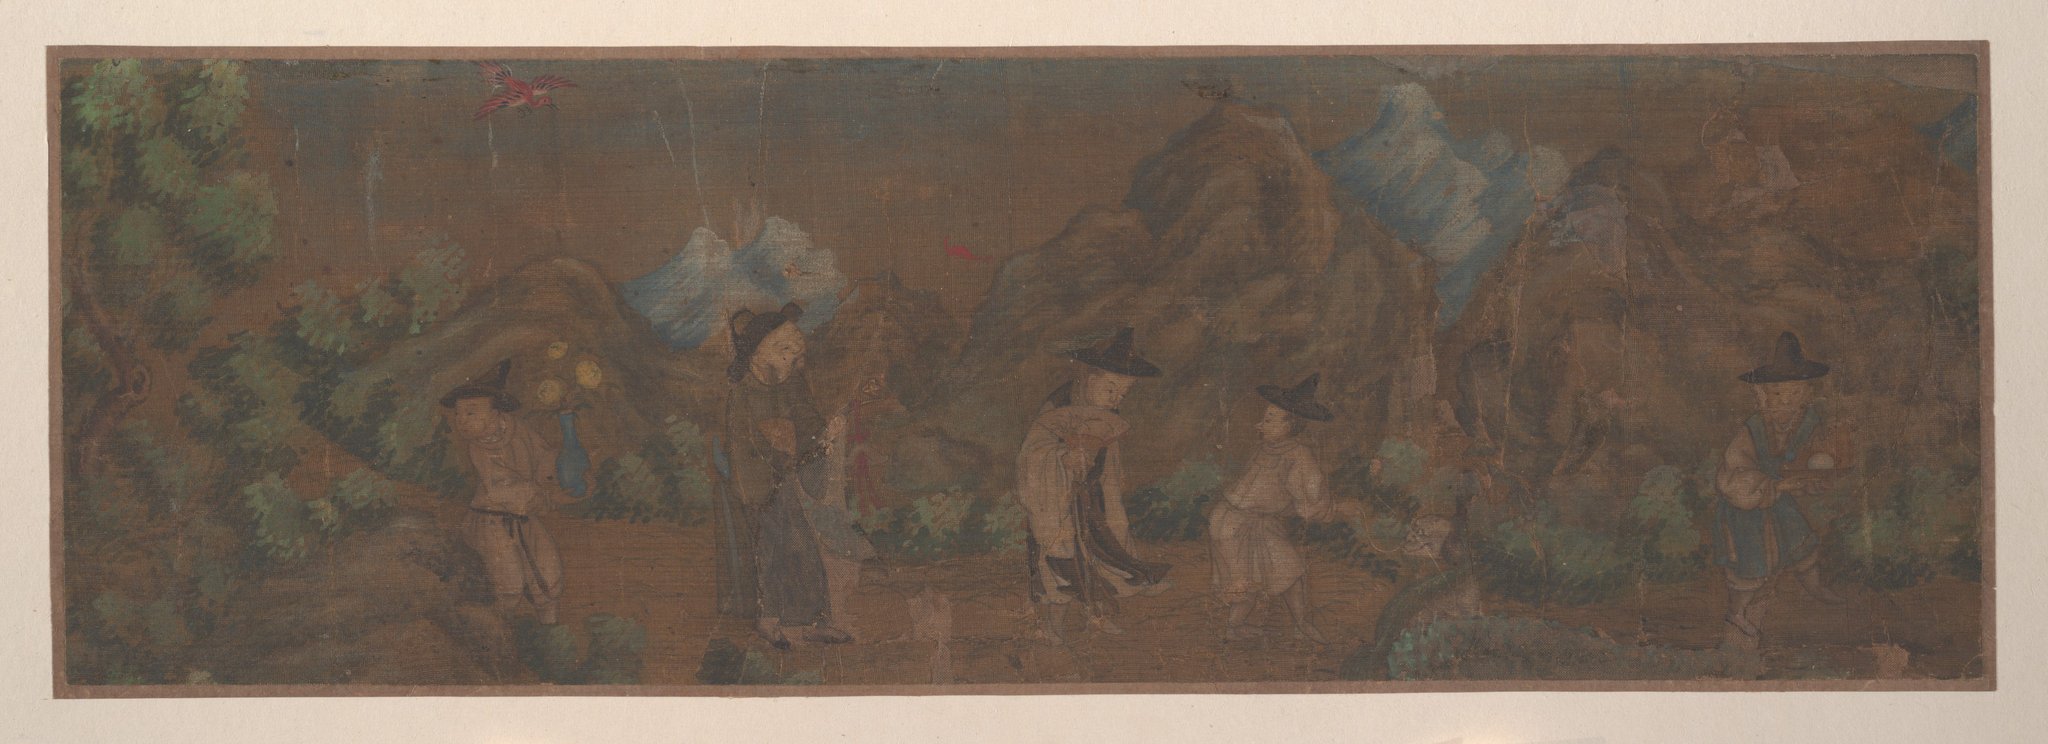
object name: album leaf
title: Landscape Painting of Figure in Woodland Setting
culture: chinese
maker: unidentified artist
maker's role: artist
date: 1644-1911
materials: silk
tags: men,mountains,landscapes